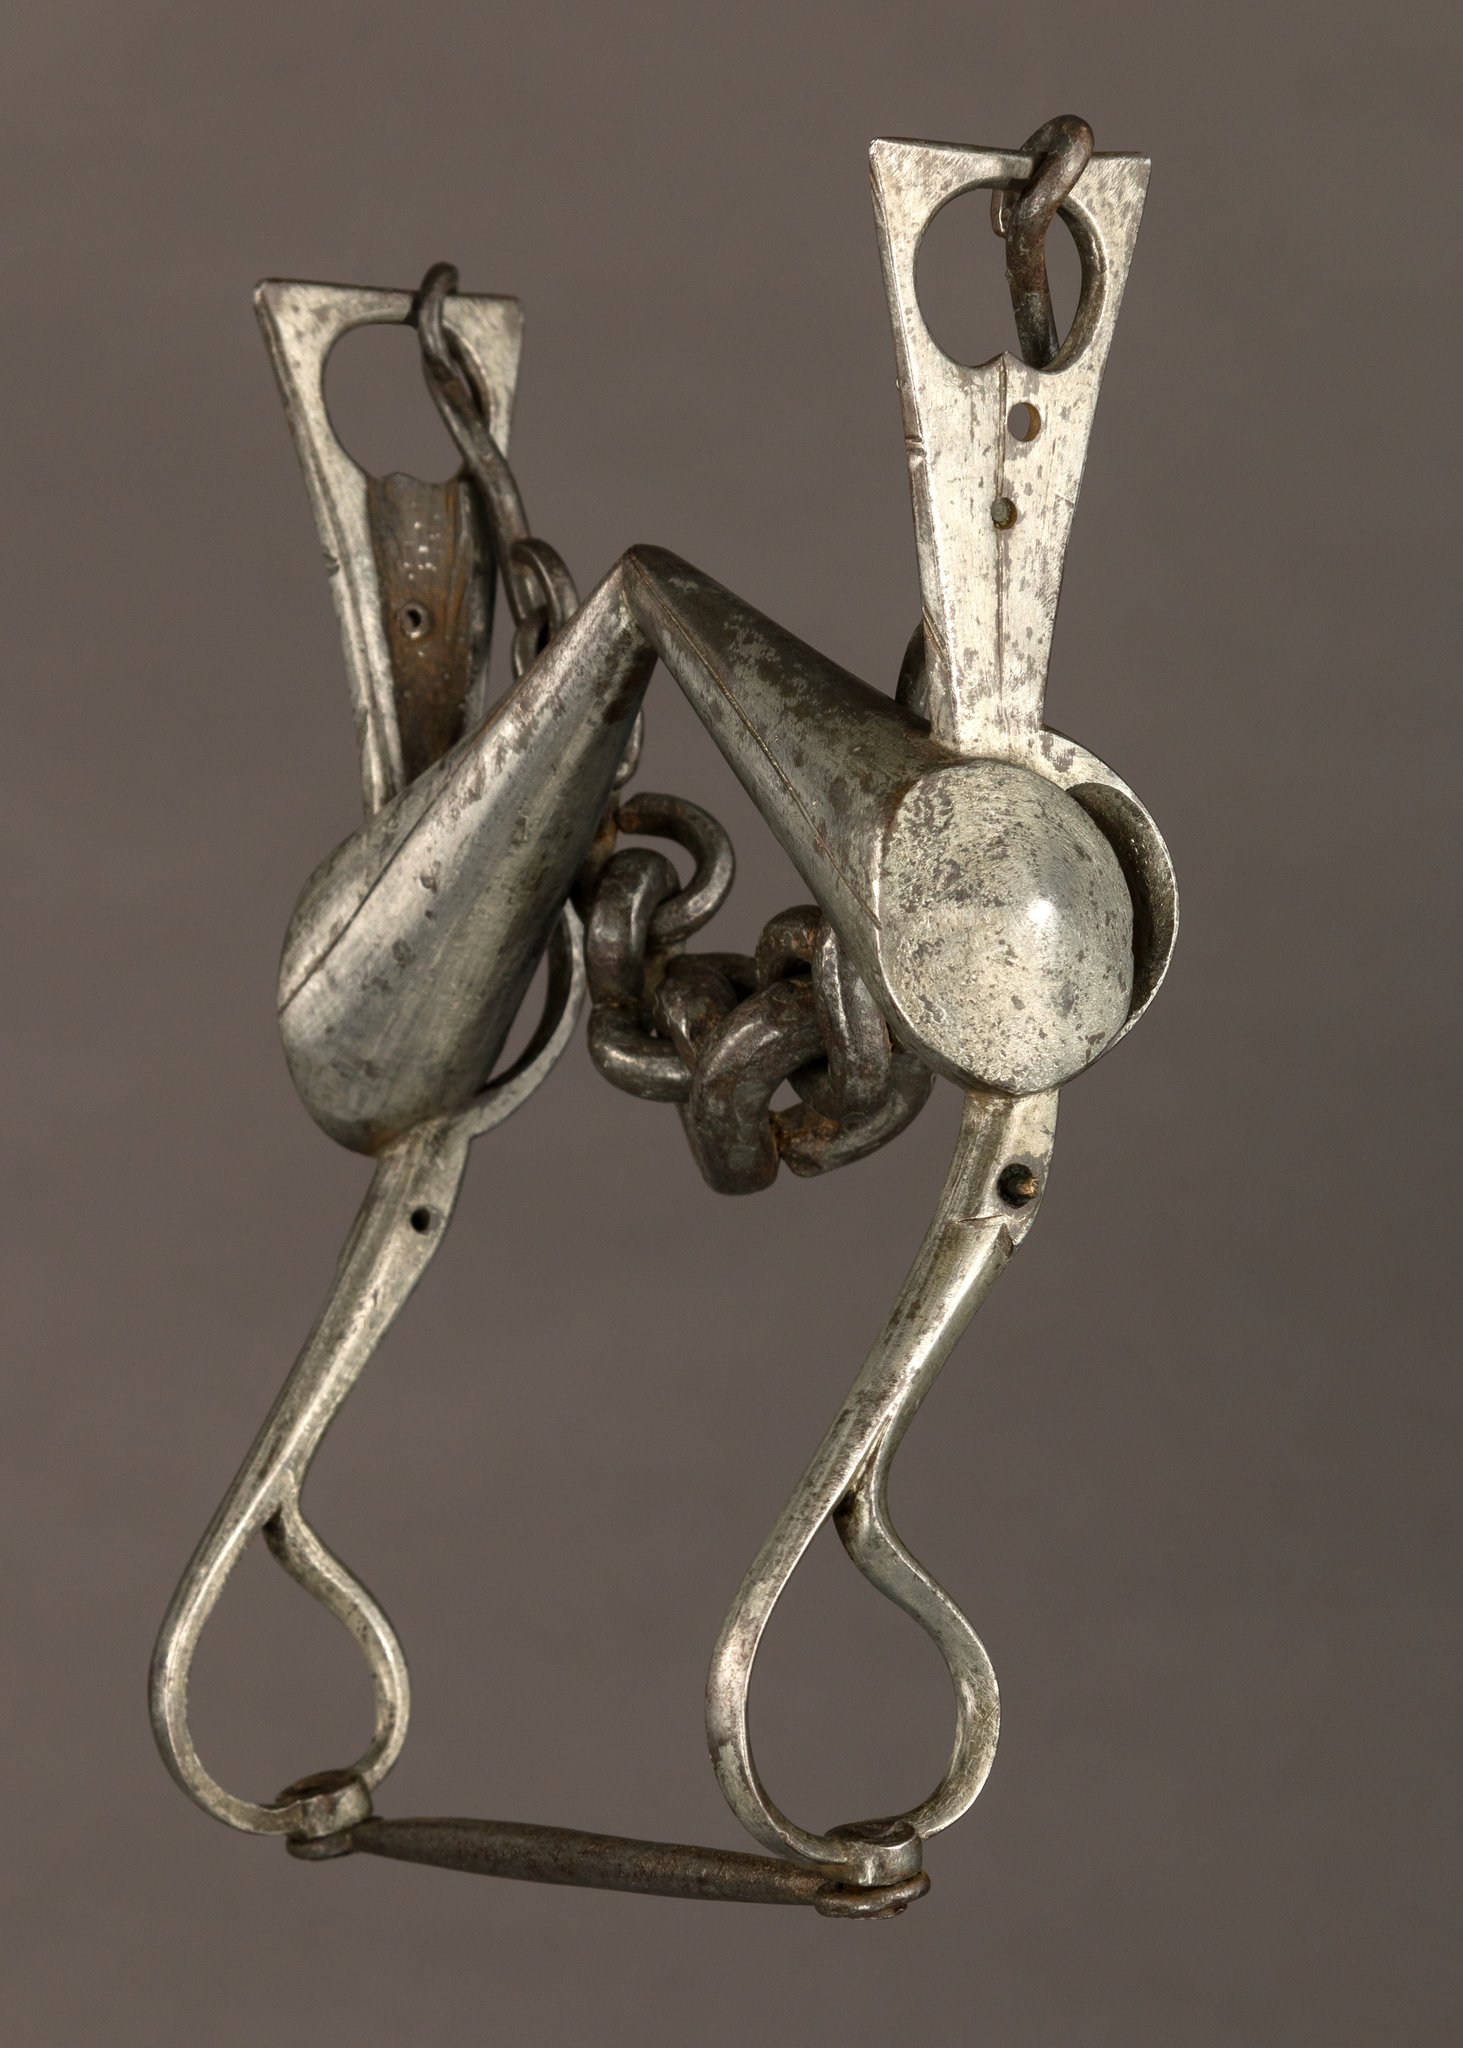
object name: bit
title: Curb Bit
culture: french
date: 1701-1800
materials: copper, metal alloy, tin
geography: france